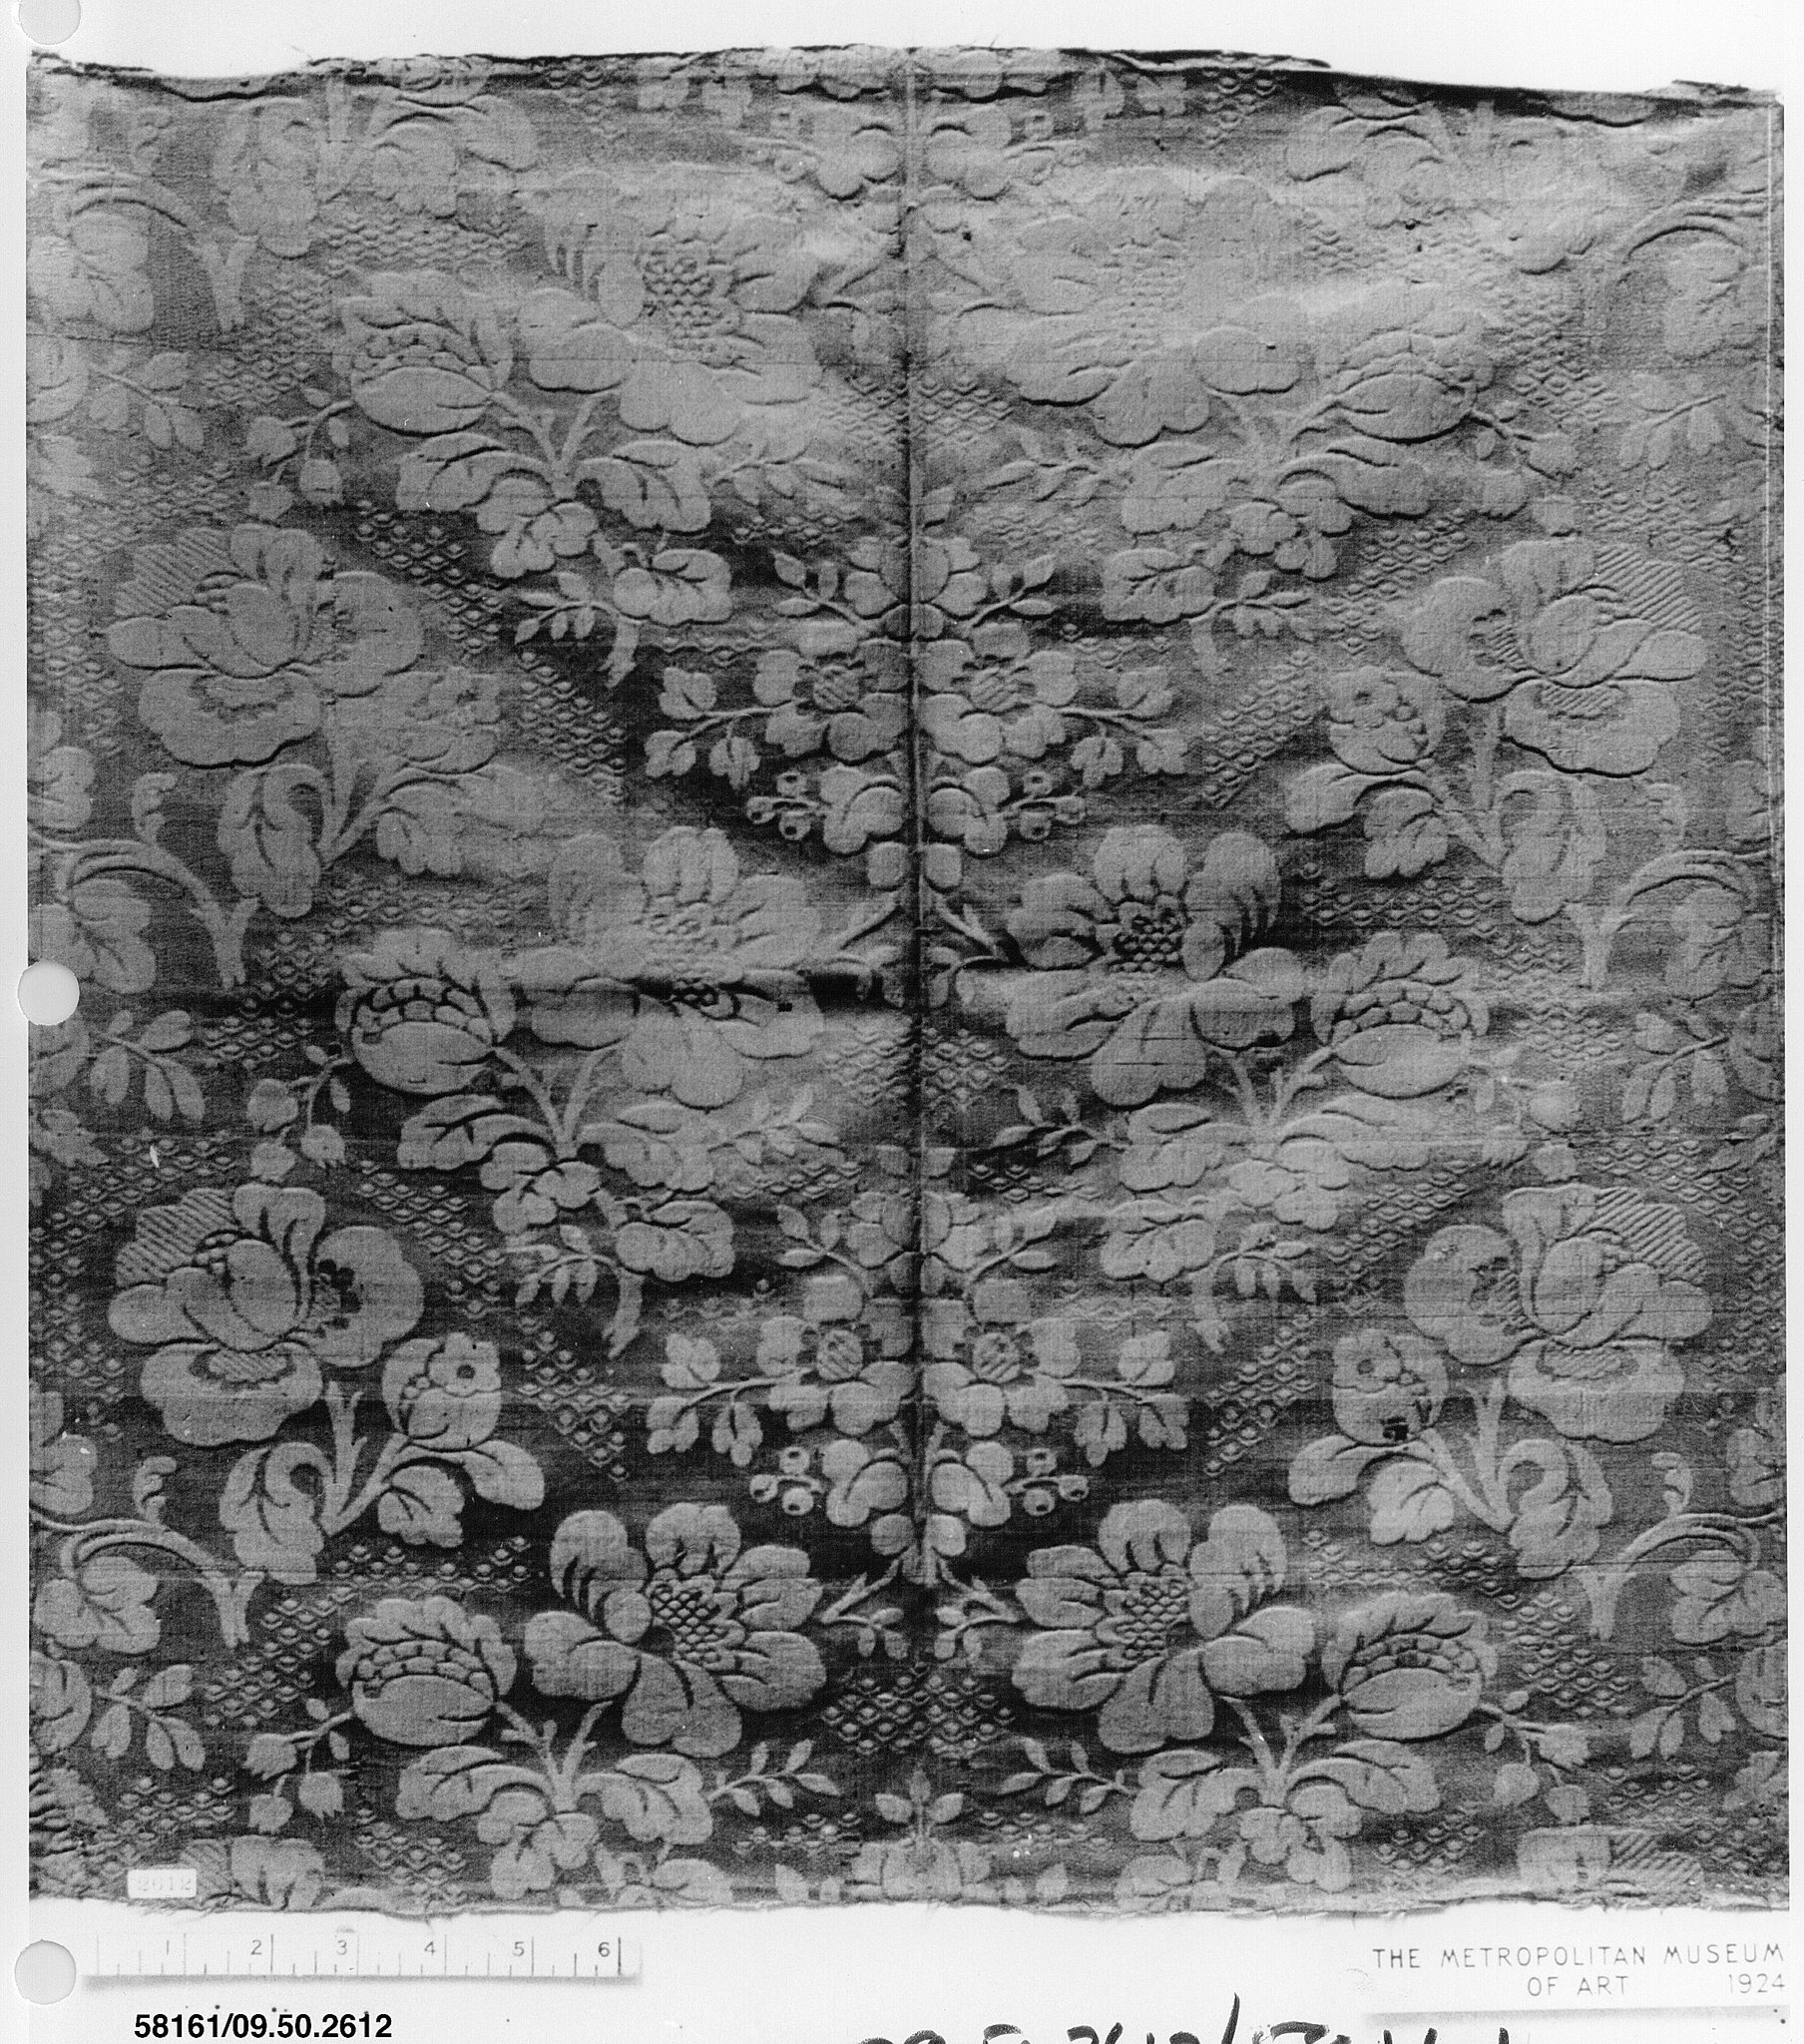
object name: piece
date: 1701-1733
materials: silk